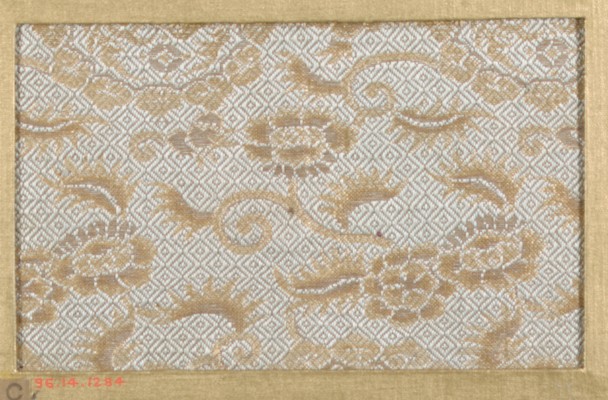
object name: piece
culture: japanese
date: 1701-1900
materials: silk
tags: leaves